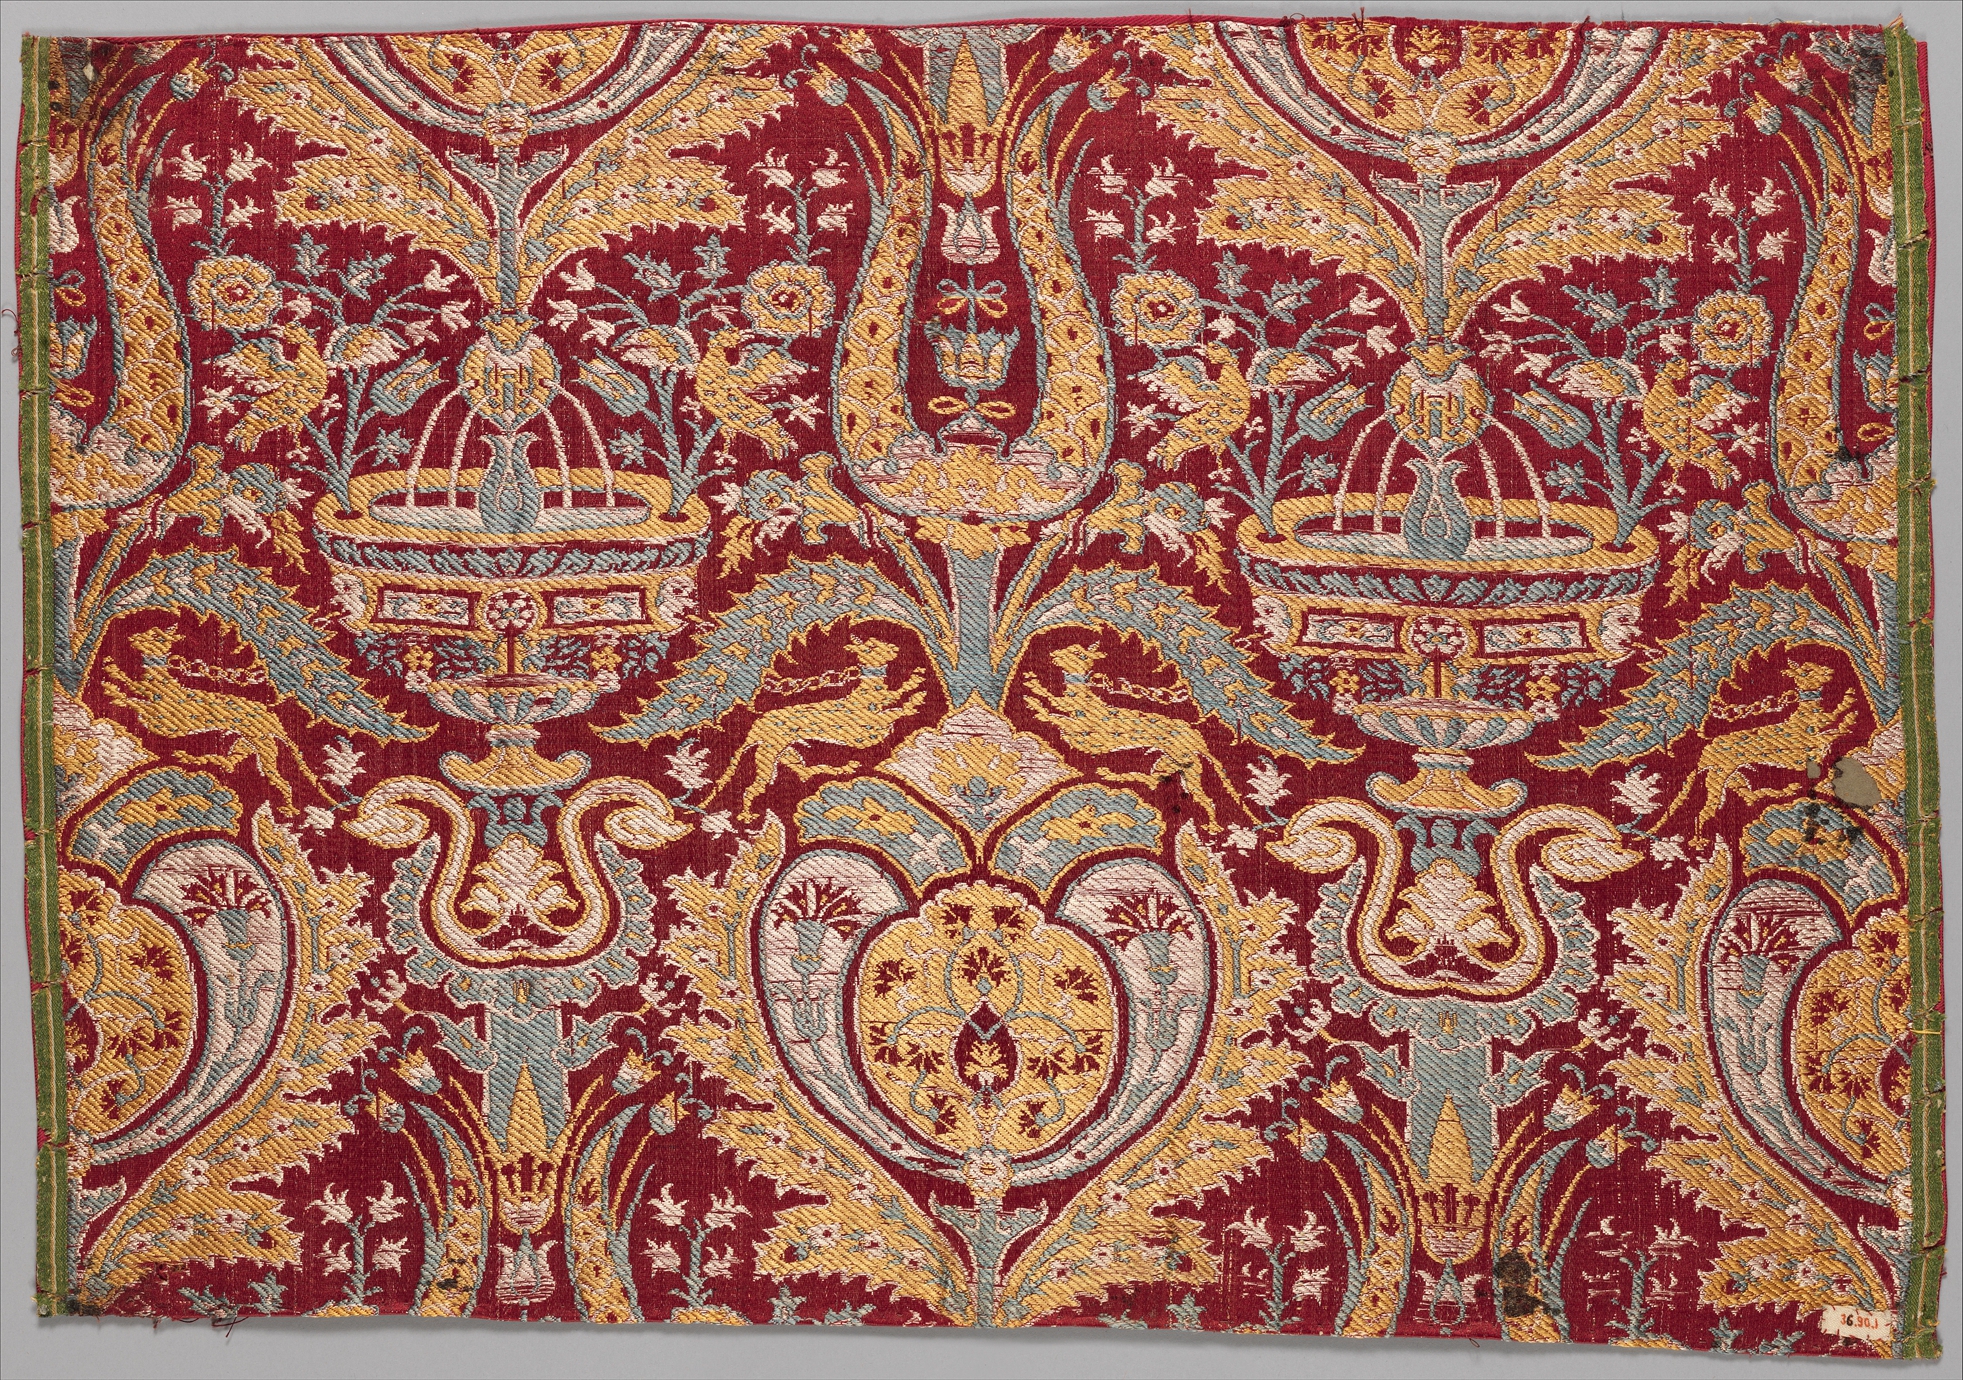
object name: piece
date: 1501-1600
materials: silk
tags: animals,birds,fountains